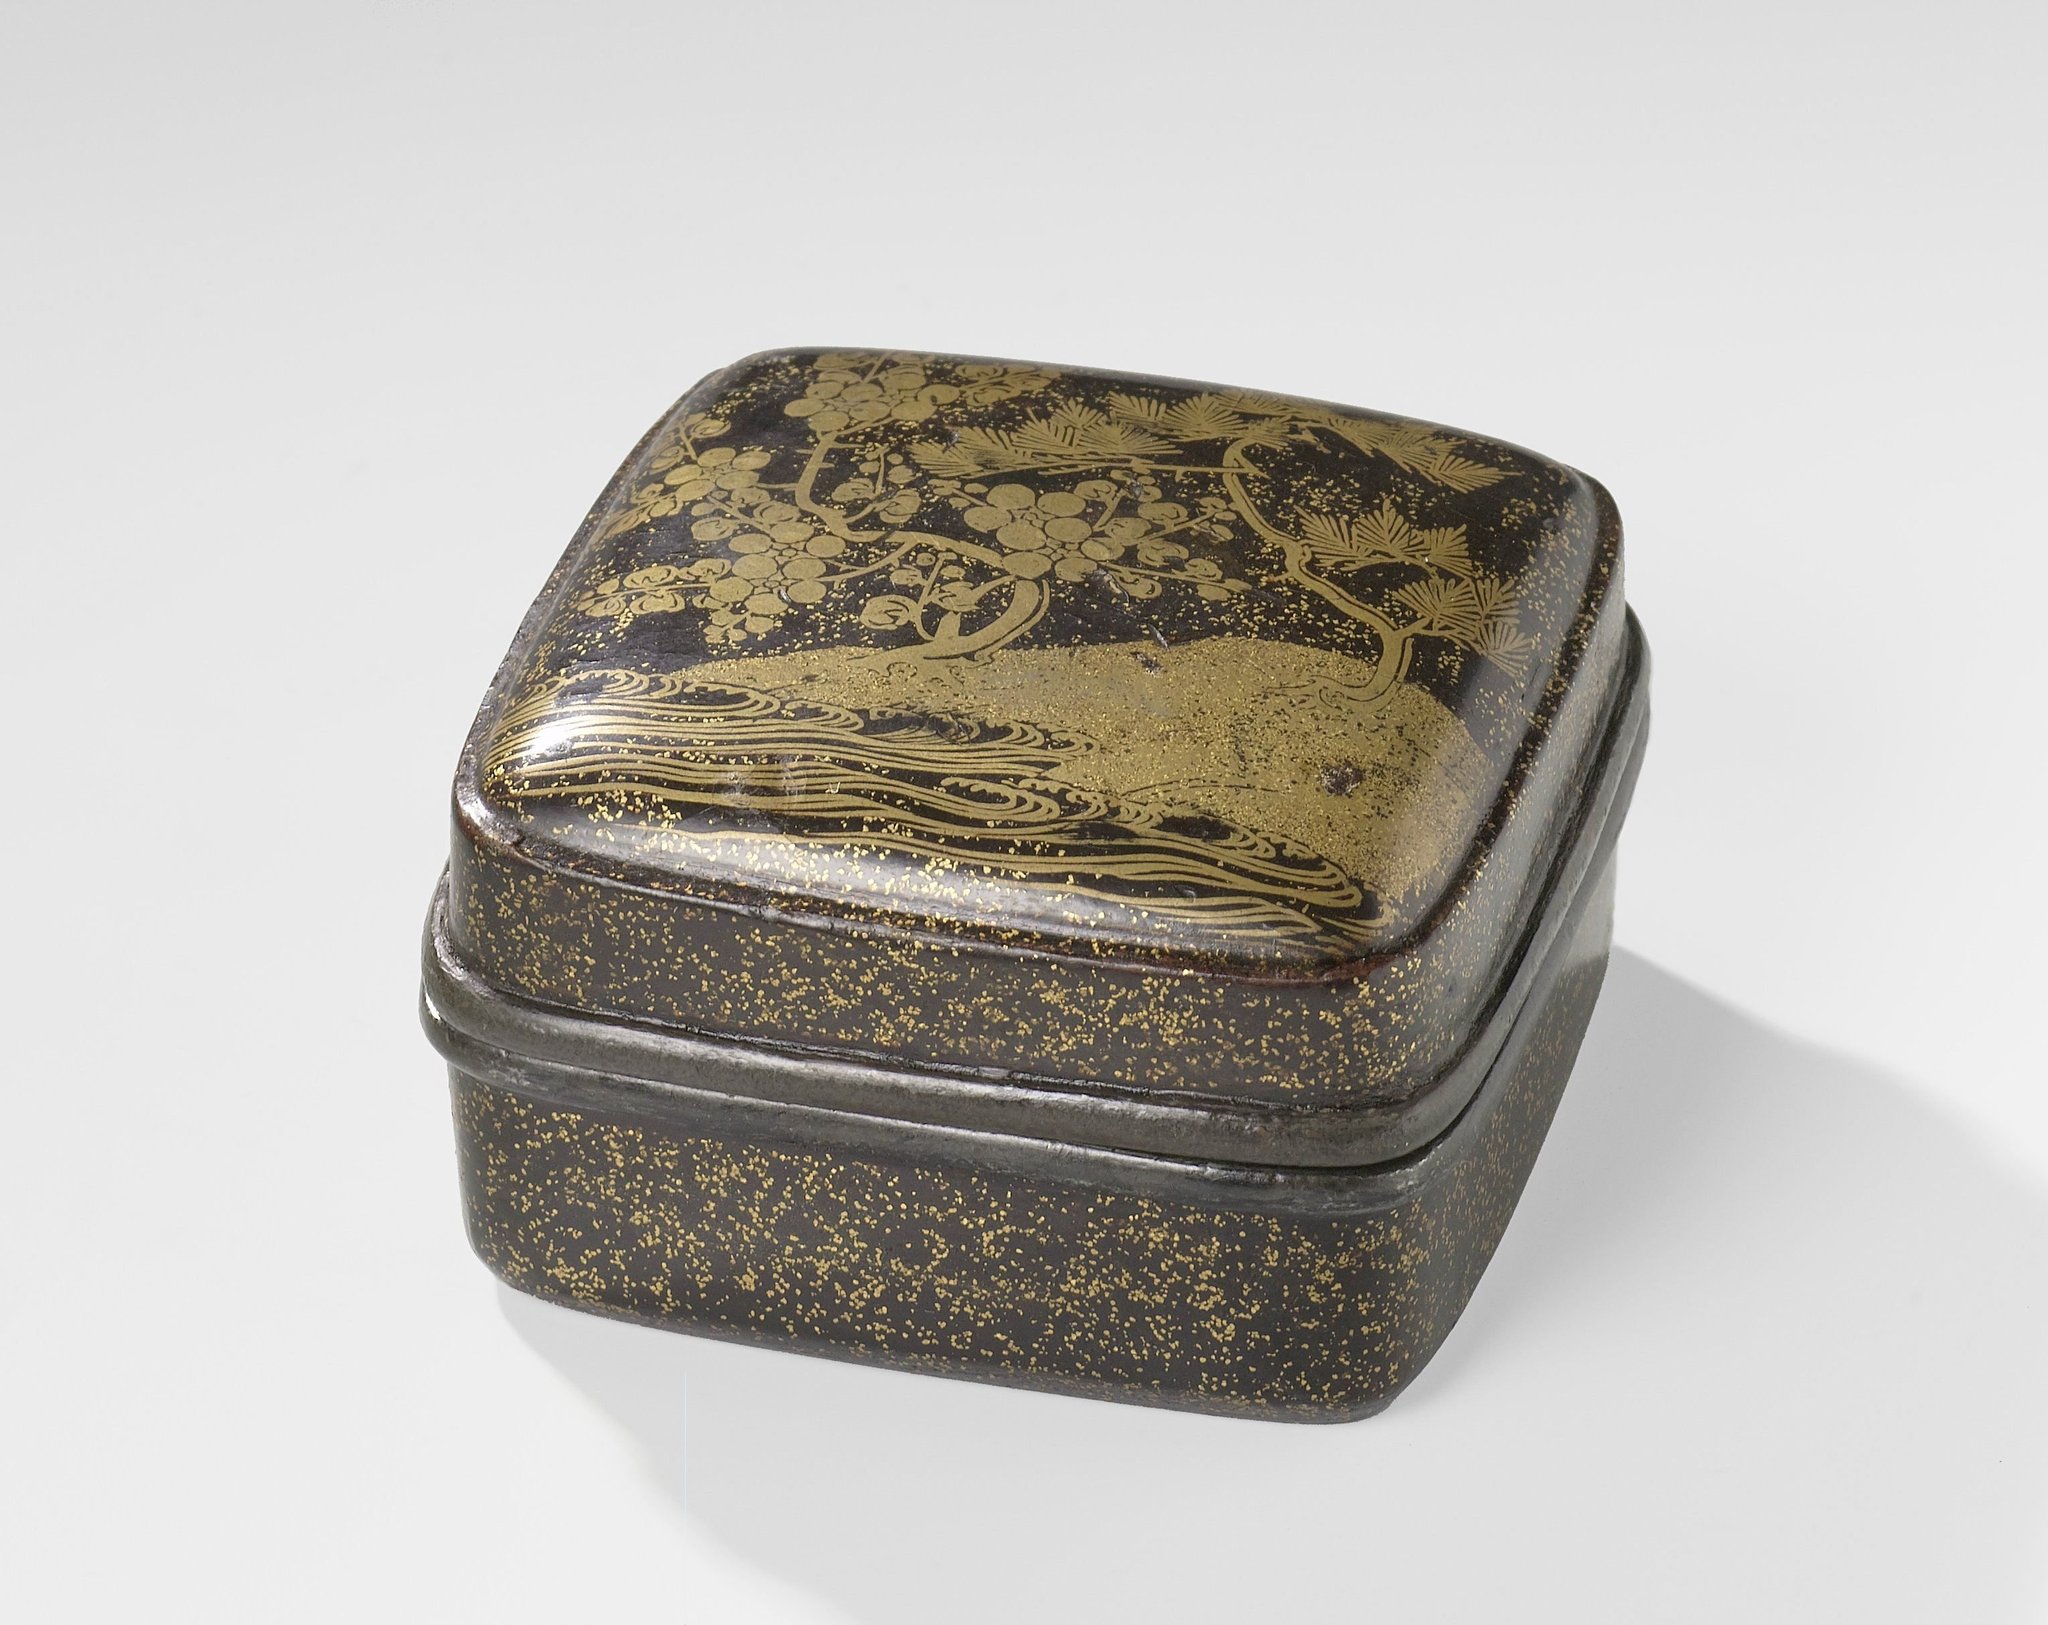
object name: incense box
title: Incense or make-up box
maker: Anonymous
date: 1500-1600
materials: gold, lacquer, wood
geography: japan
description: Unlike its oblong neighbour with the chrysanthemum motif, this little box was not decorated in relief, but in smoothly finished lacquer. In the 18th and 19th centuries such boxes served as incense containers. However, in the 16th century they were also used to keep make-up.